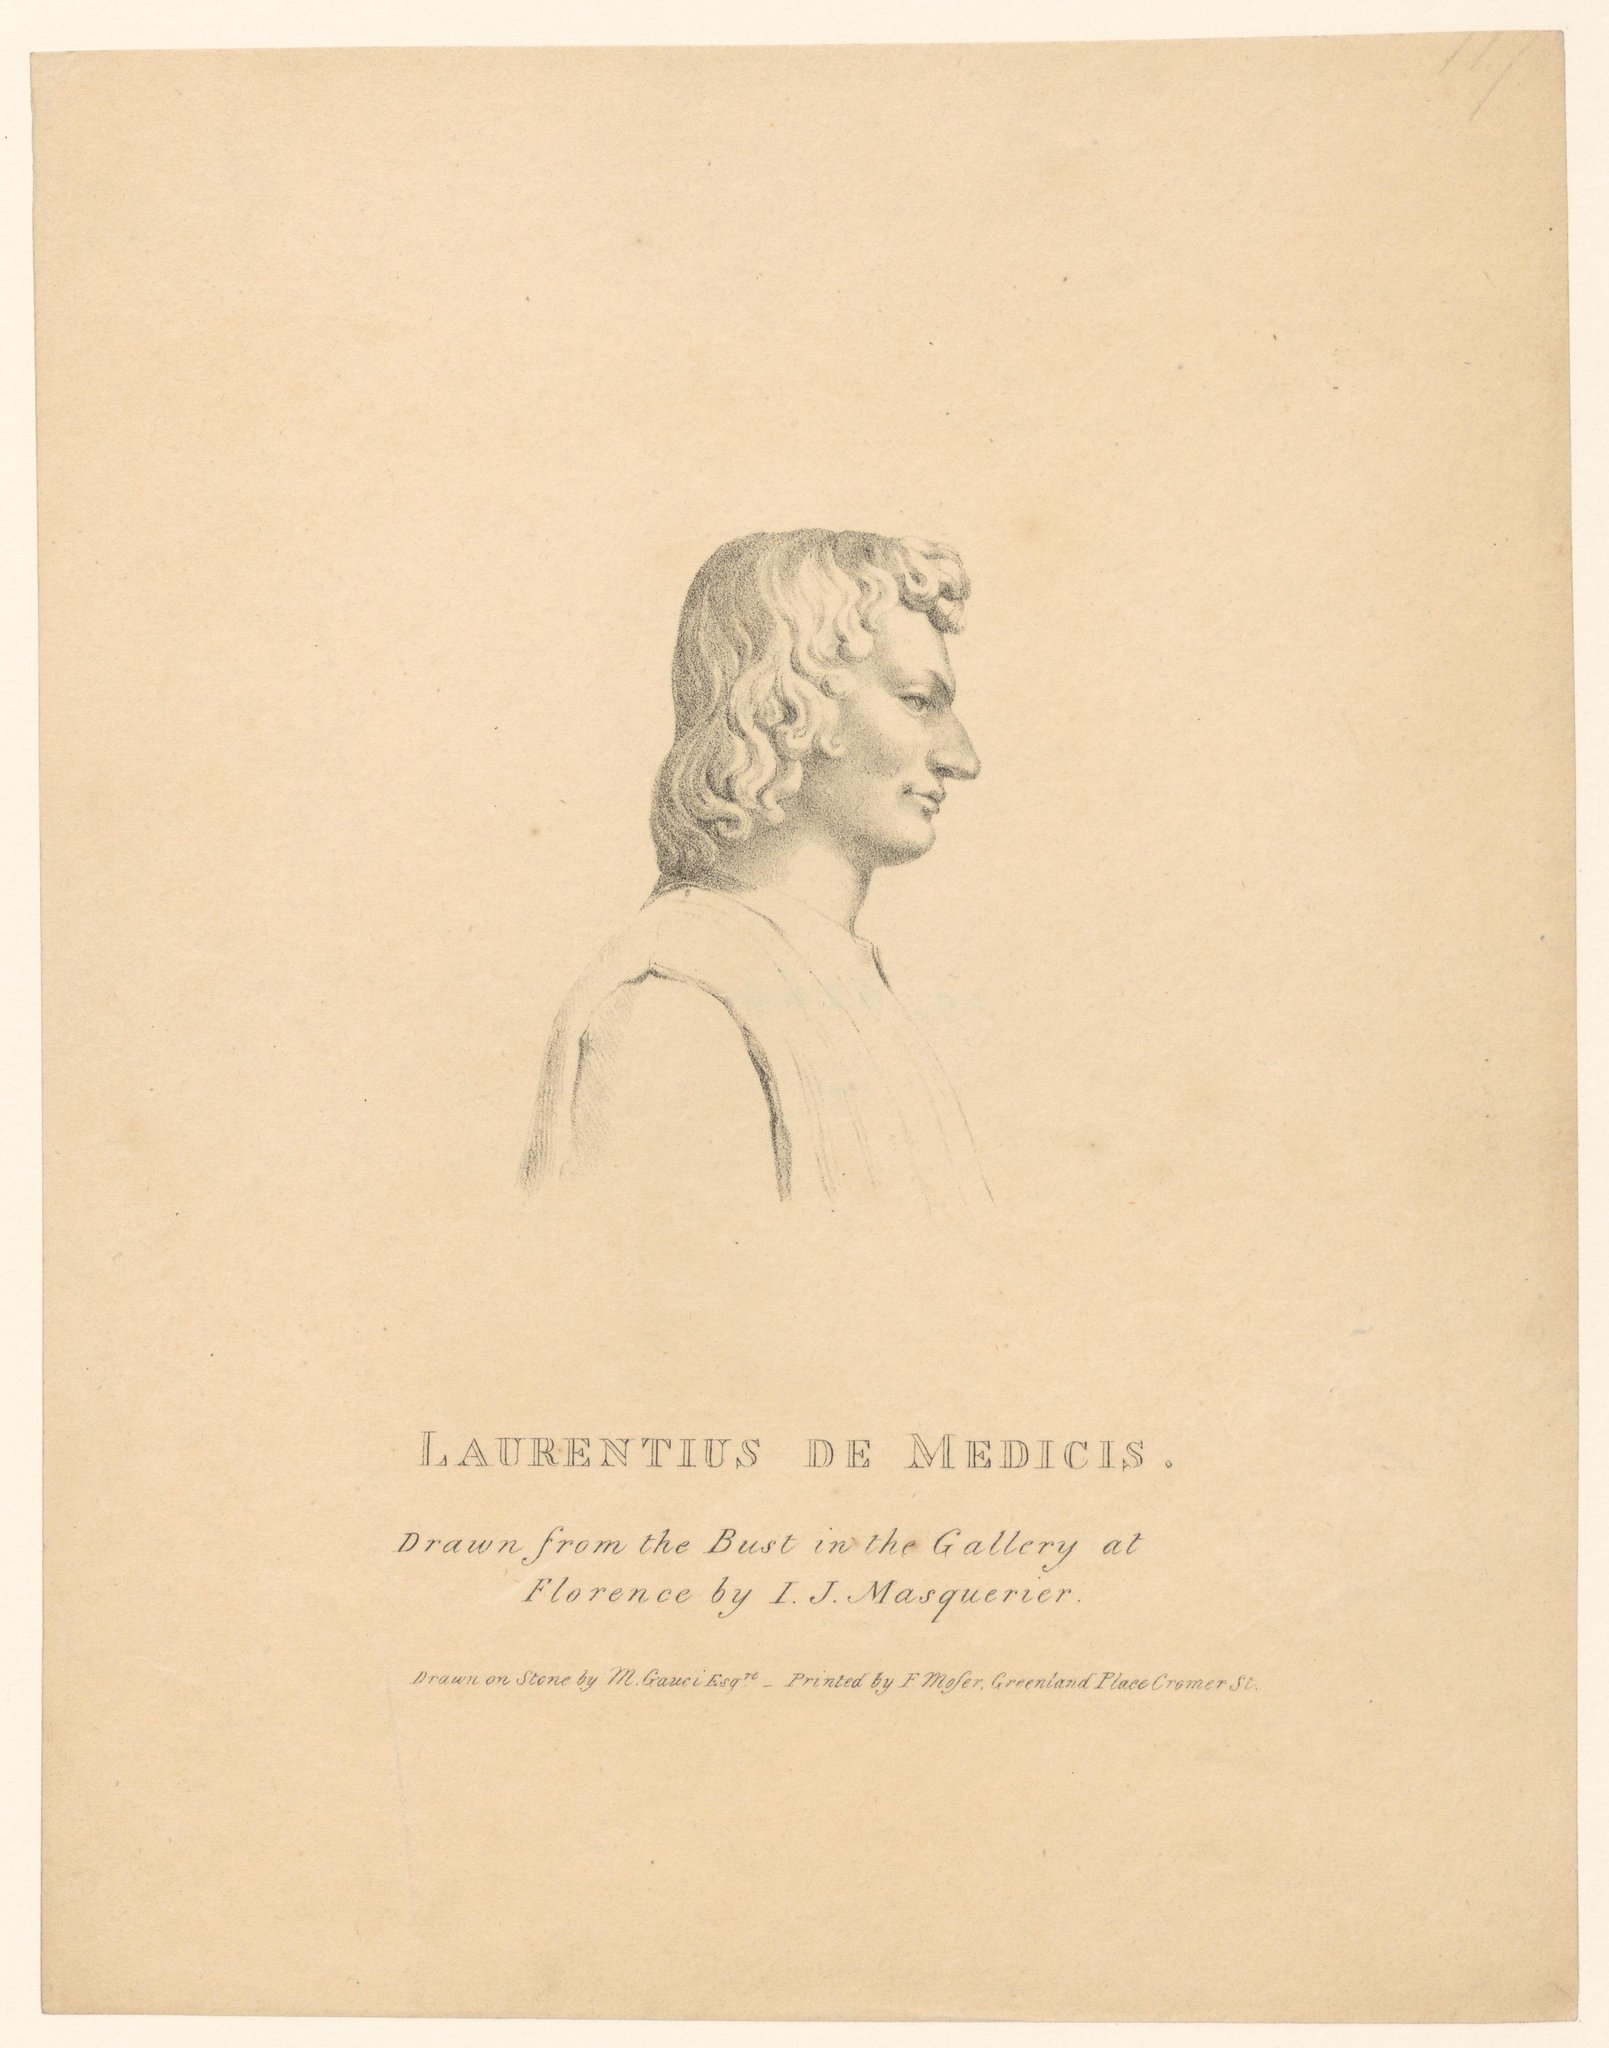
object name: print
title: Laurentius de Medicis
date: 1820-1850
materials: paper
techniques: lithograph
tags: politician, adult man, historical persons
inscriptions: collector's mark: Lugt 2228